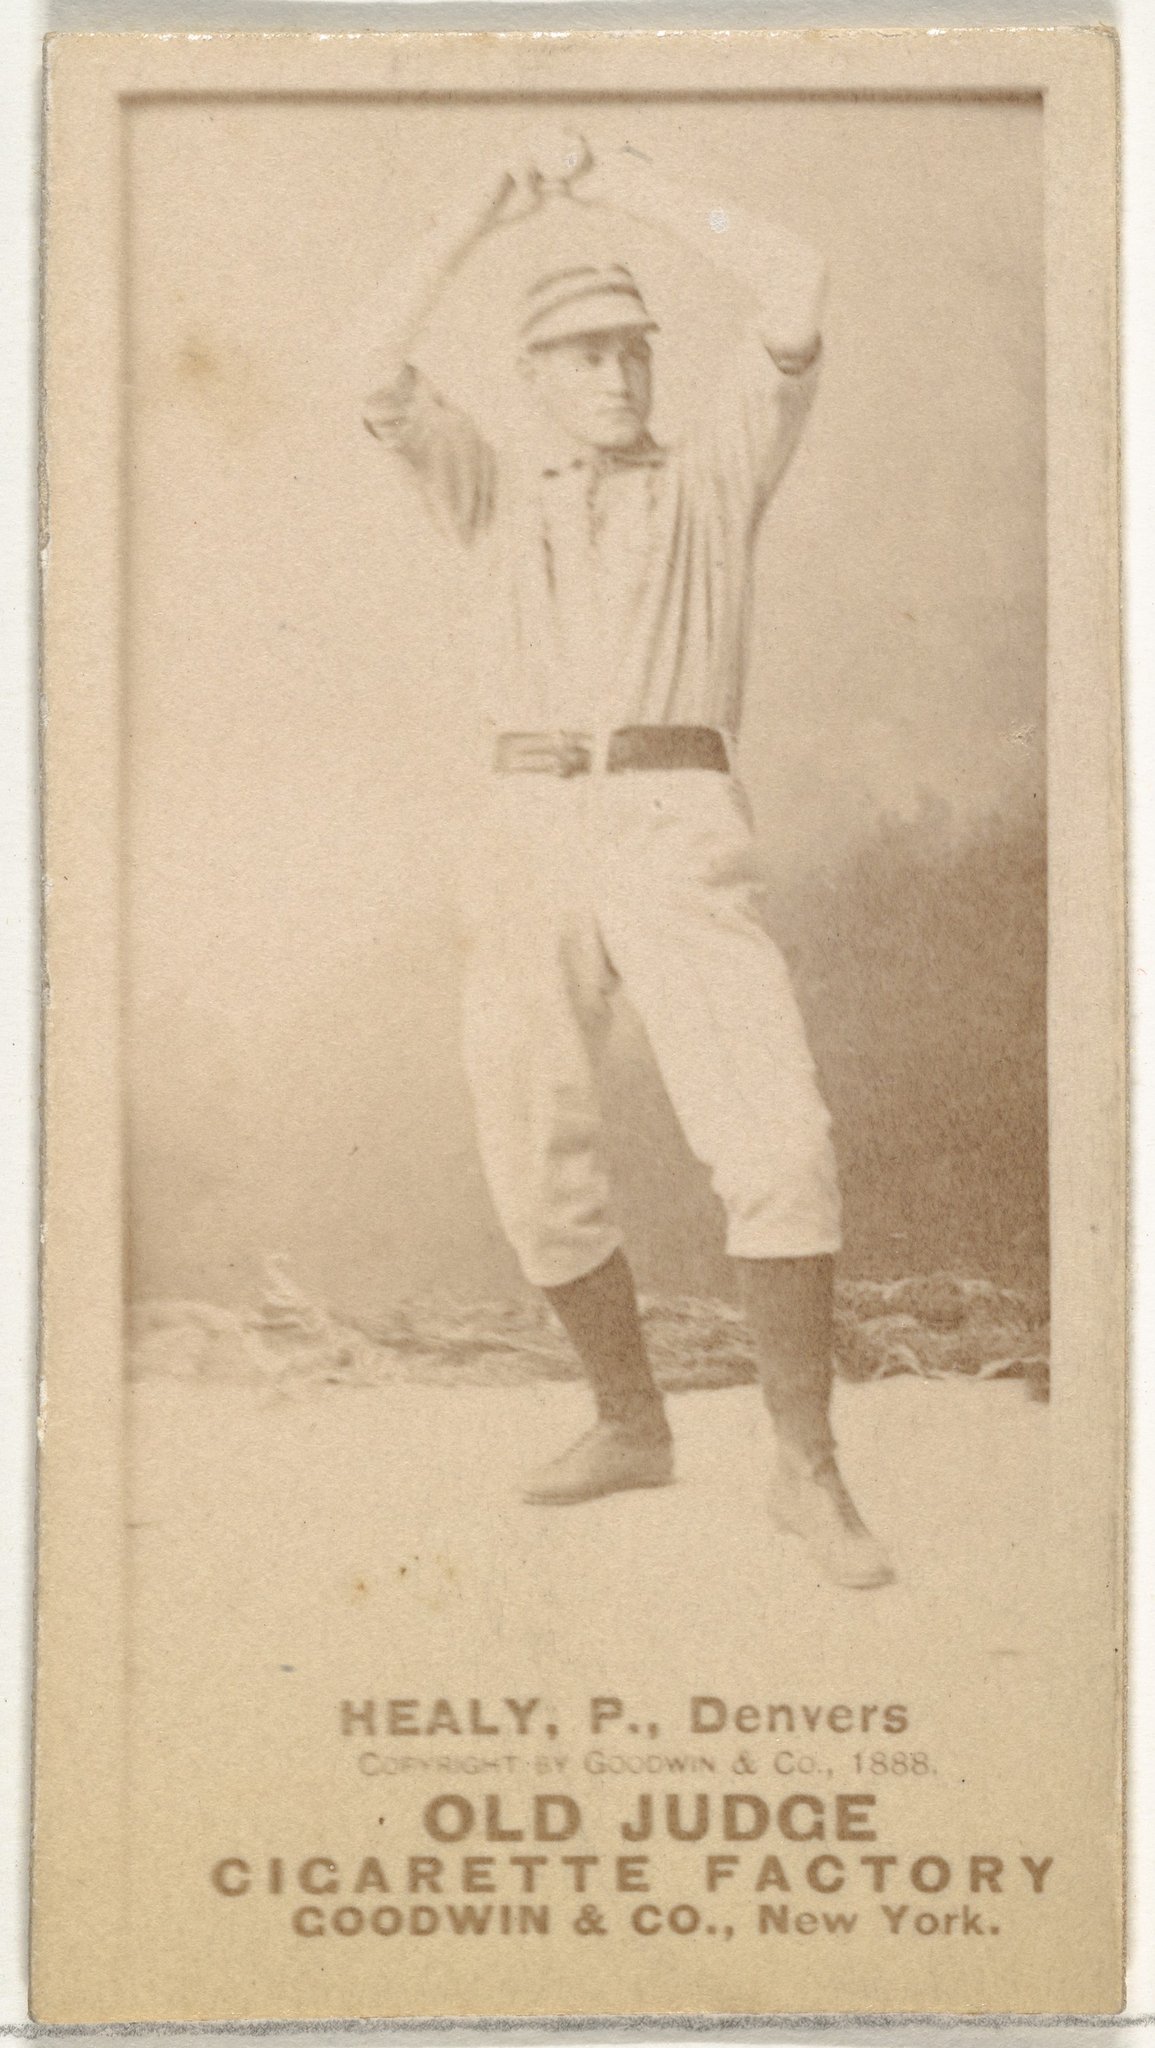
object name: baseball card, photograph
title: Healy, Pitcher, Denver, from the Old Judge series (N172) for Old Judge Cigarettes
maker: goodwin & company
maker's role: publisher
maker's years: 1850-1950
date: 1888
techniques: albumen silver print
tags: men,portraits,baseball,athletes